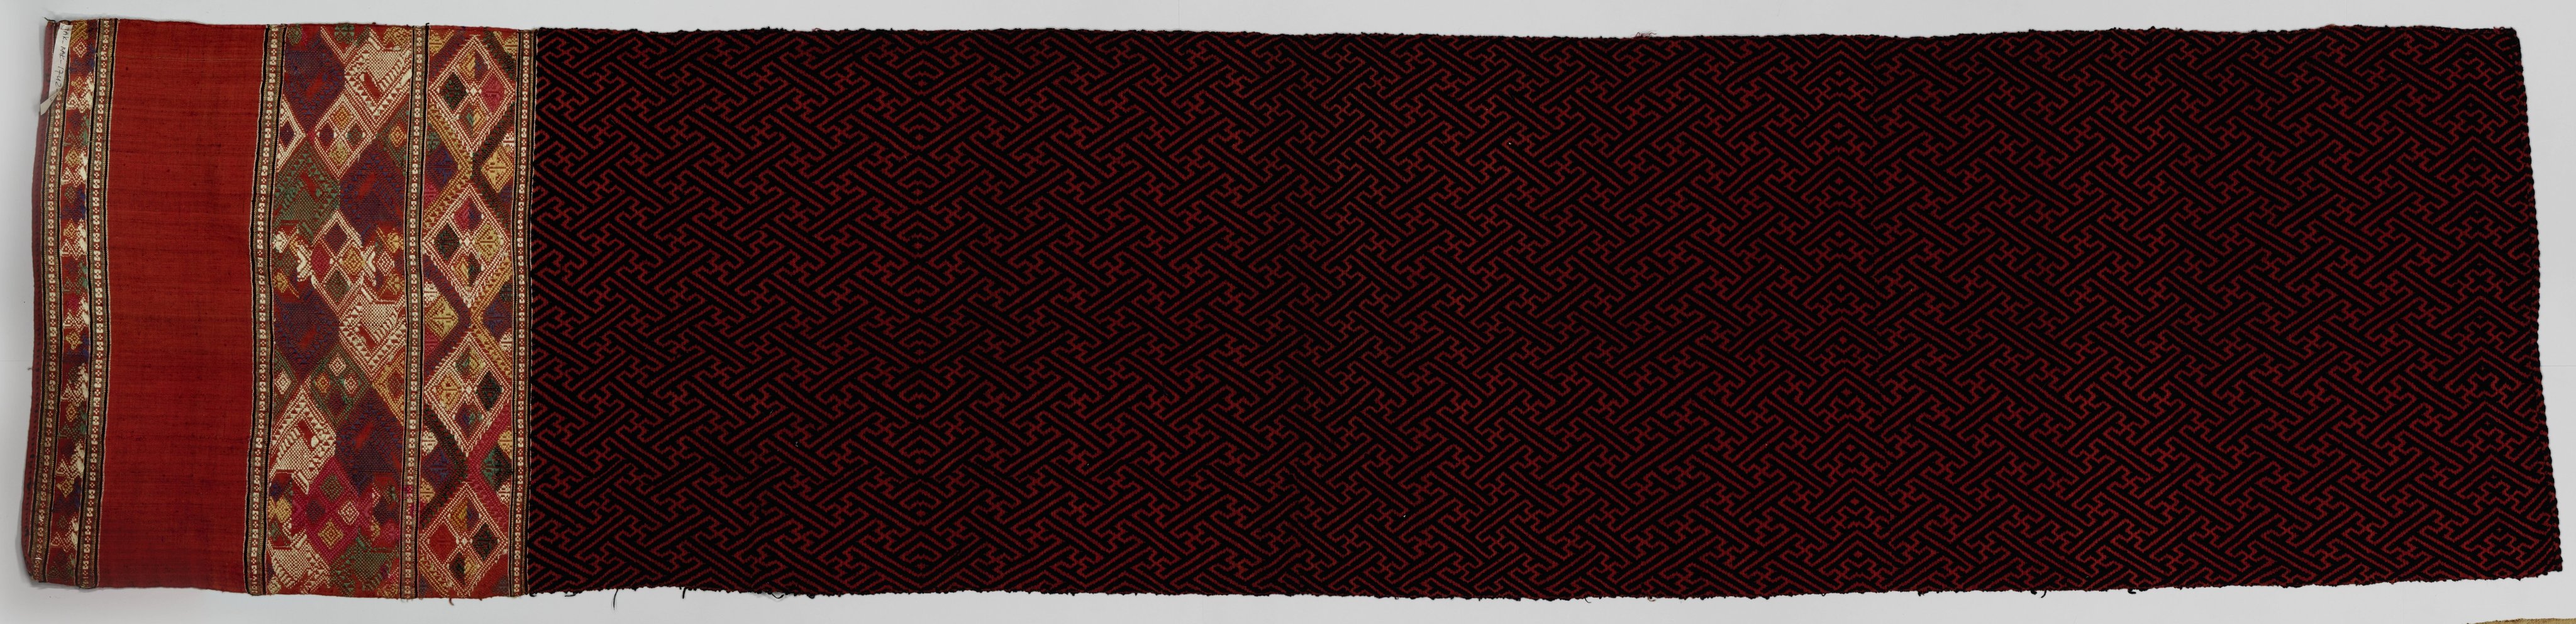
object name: cloth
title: Pa hom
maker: Anonymous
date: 1900-1949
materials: cotton, silk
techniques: weave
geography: laos